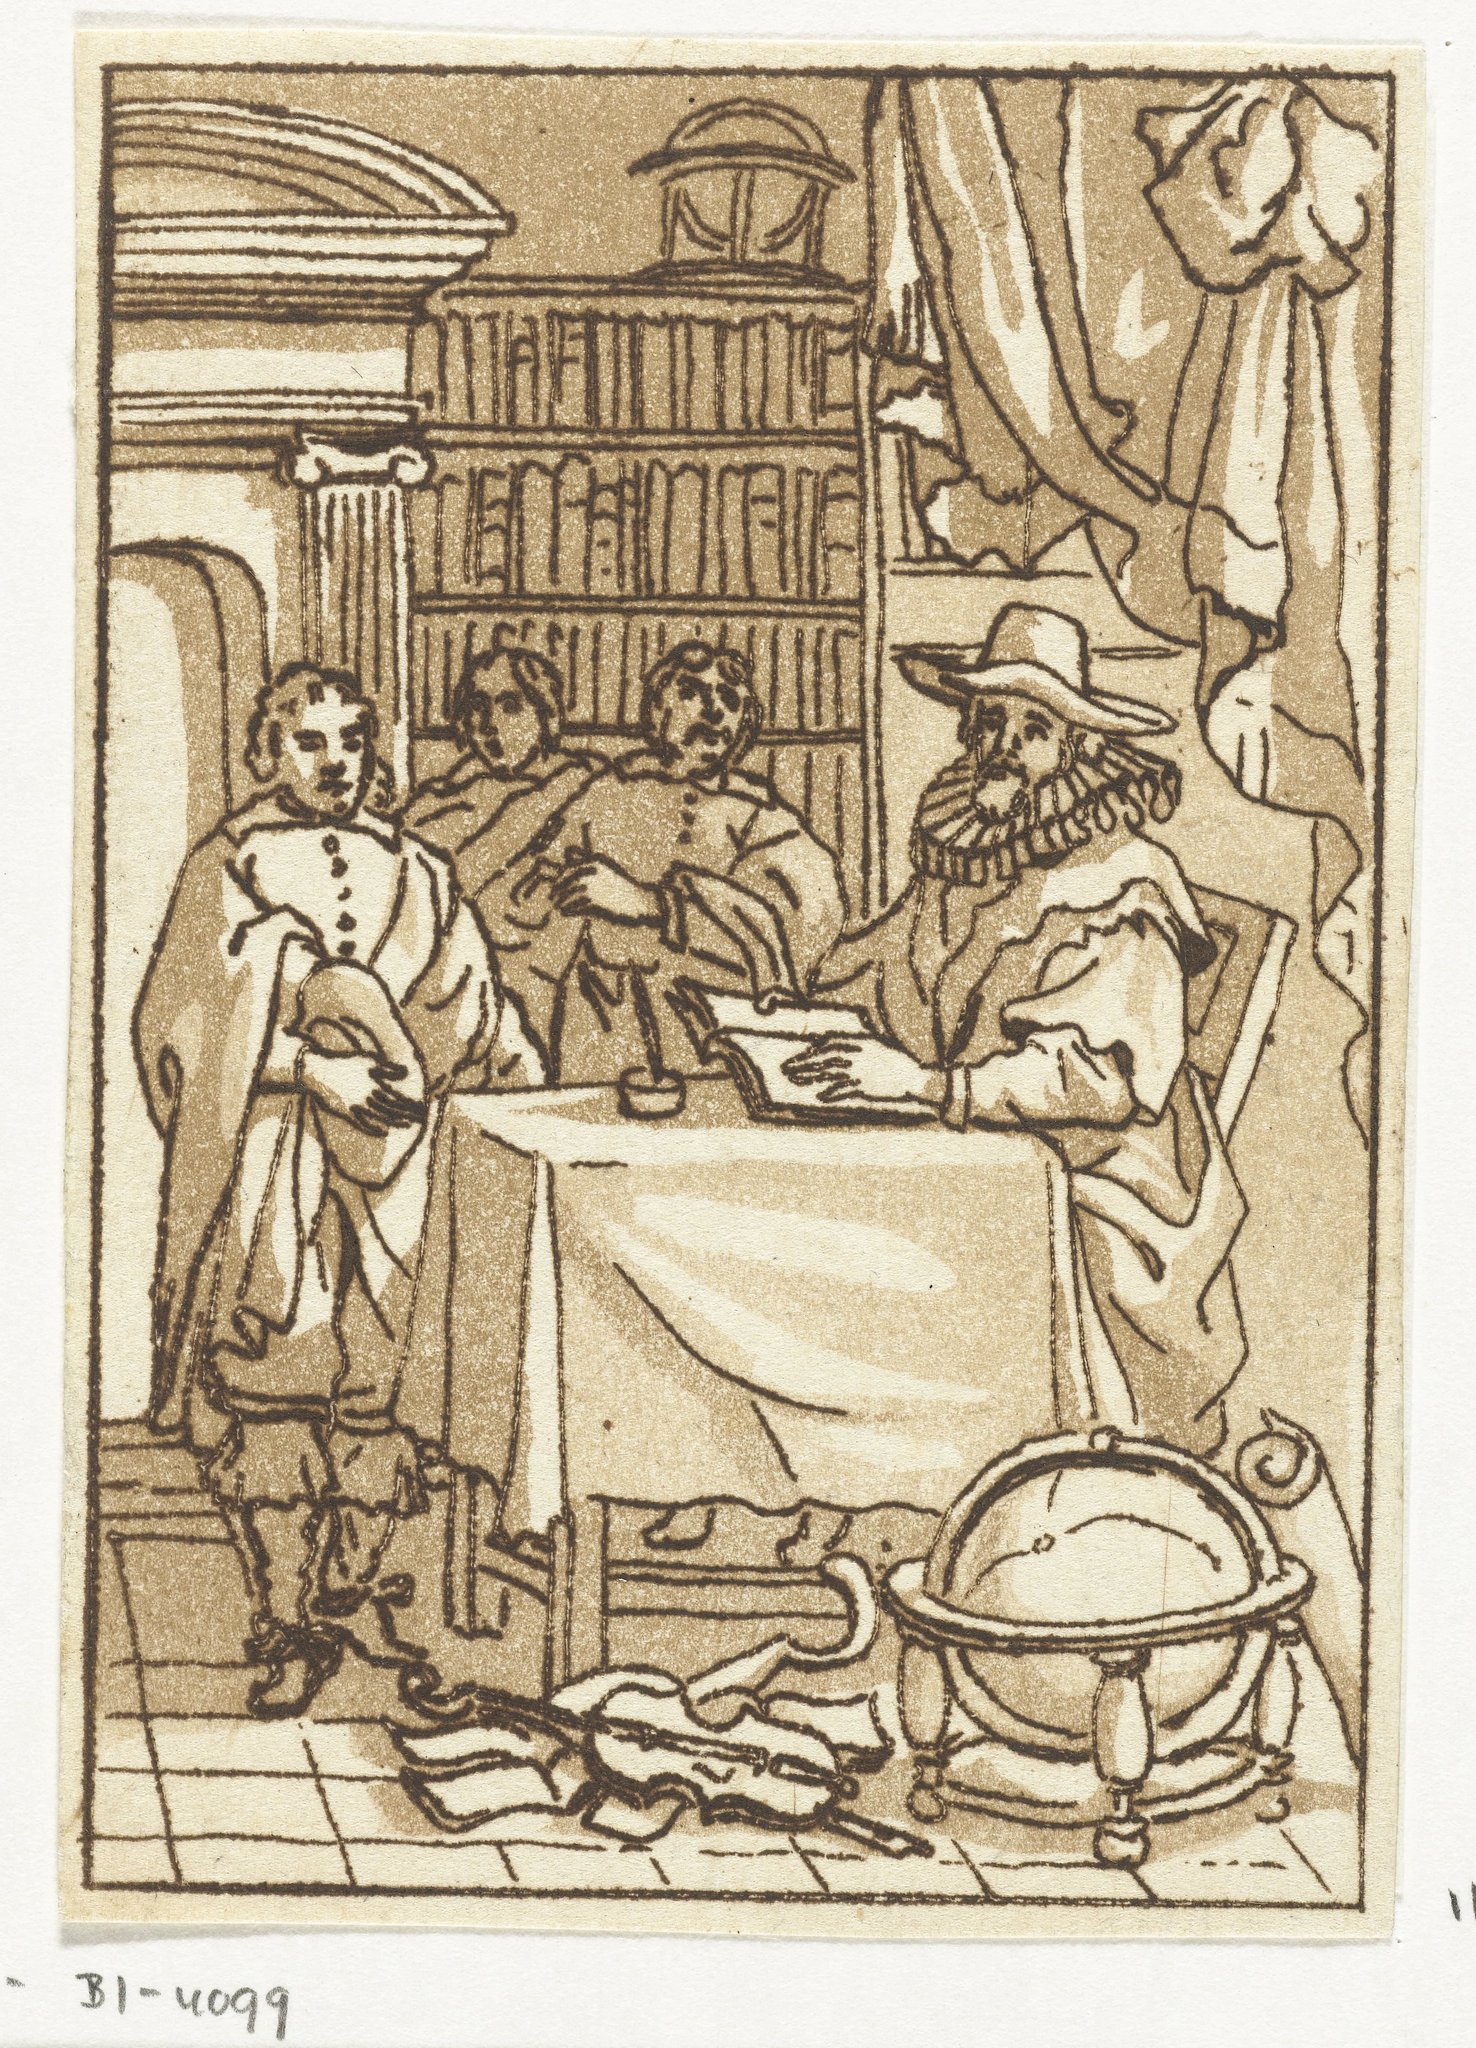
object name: print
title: Geleerde in studeervertrek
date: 1778-1838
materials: paper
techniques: aquatint, etching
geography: netherlands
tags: scholar in his study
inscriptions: collector's mark: Lugt 2228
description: Een geleerde zit achter een schrijftafel in zijn studeervertrek en ontvangt drie mannen. Op de grond naast de tafel staat een globe en er ligt een viool. Tegen de muur staat een boekenkast. Op de kast staat een tweede globe.